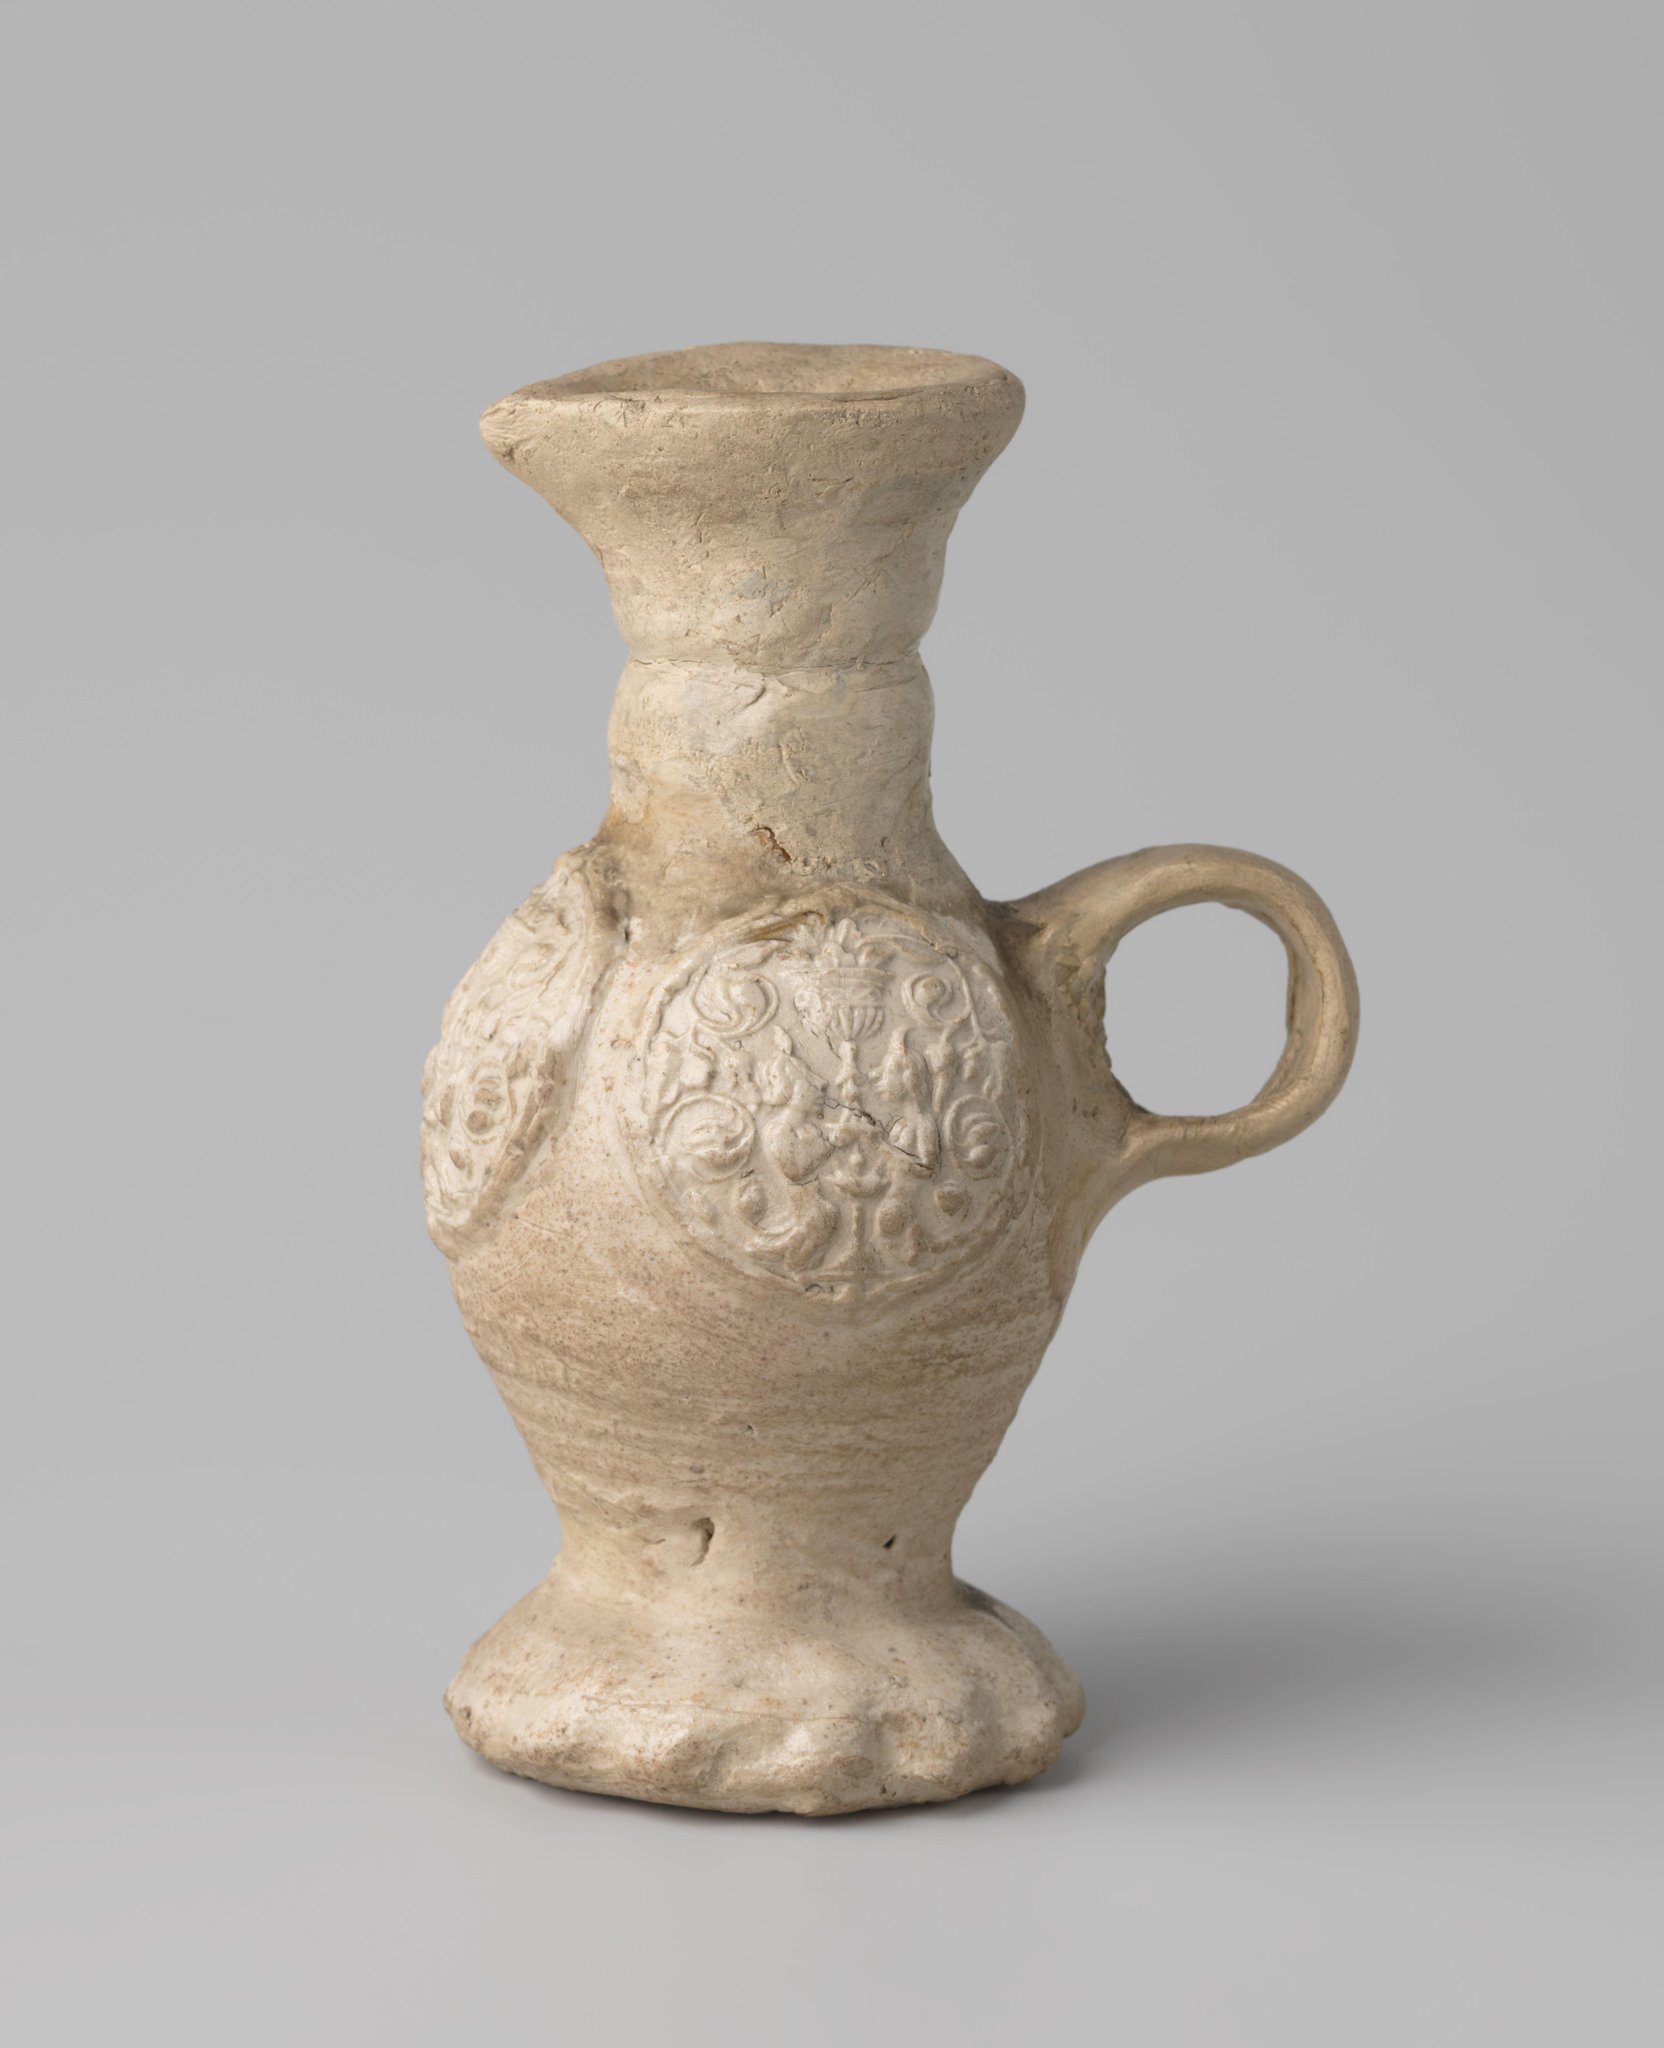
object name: cup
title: Beaker 'trichterhalsbecher' with medallions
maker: anno knütgen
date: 1560-1590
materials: glaze, stoneware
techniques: firing, forming, relief, turning, vitrification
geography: siegburg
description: Beker (trechterhalsbeker) van steengoed met golvende voet en eivormig lichaam met trechtervormige nek met tuit. Het C-vormige oor is bevestigd aan de schouder en buik. Op de buik in reliëf driemaal een medaillon met een bokaal gedragen door twee figuren omringd door bladranken. Draairingen op het lichaam. Nek en oor zijn gerestaureerd. Siegburg.